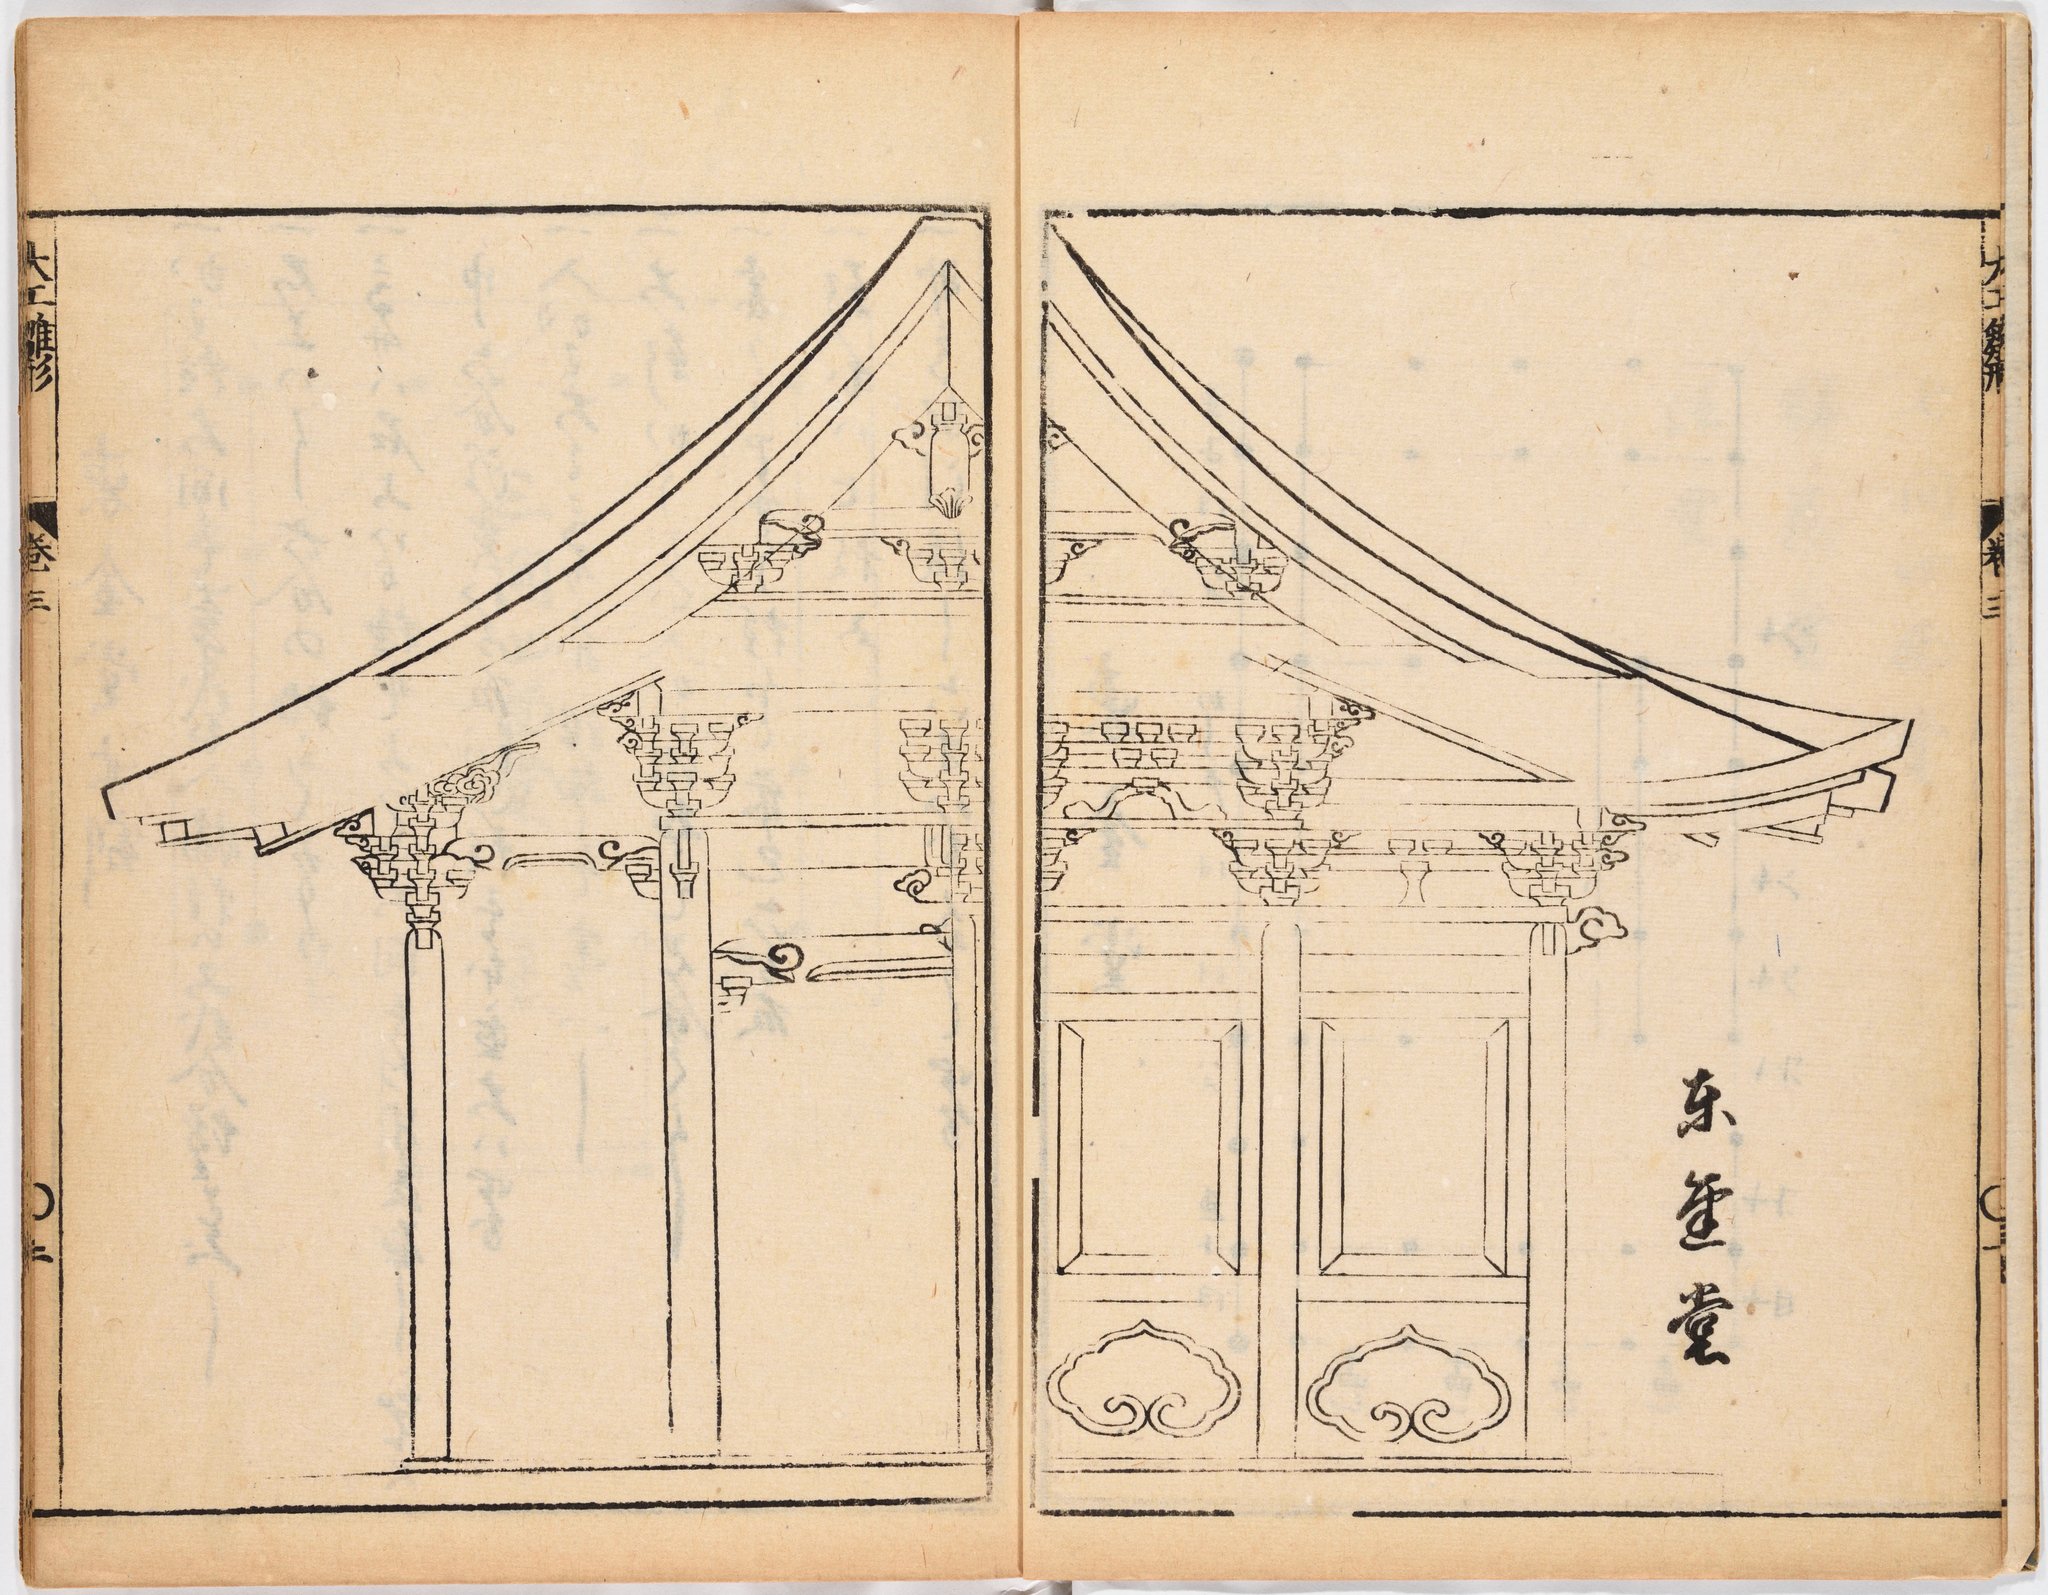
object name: illustrated book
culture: japanese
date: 1893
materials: ink, paper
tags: architecture